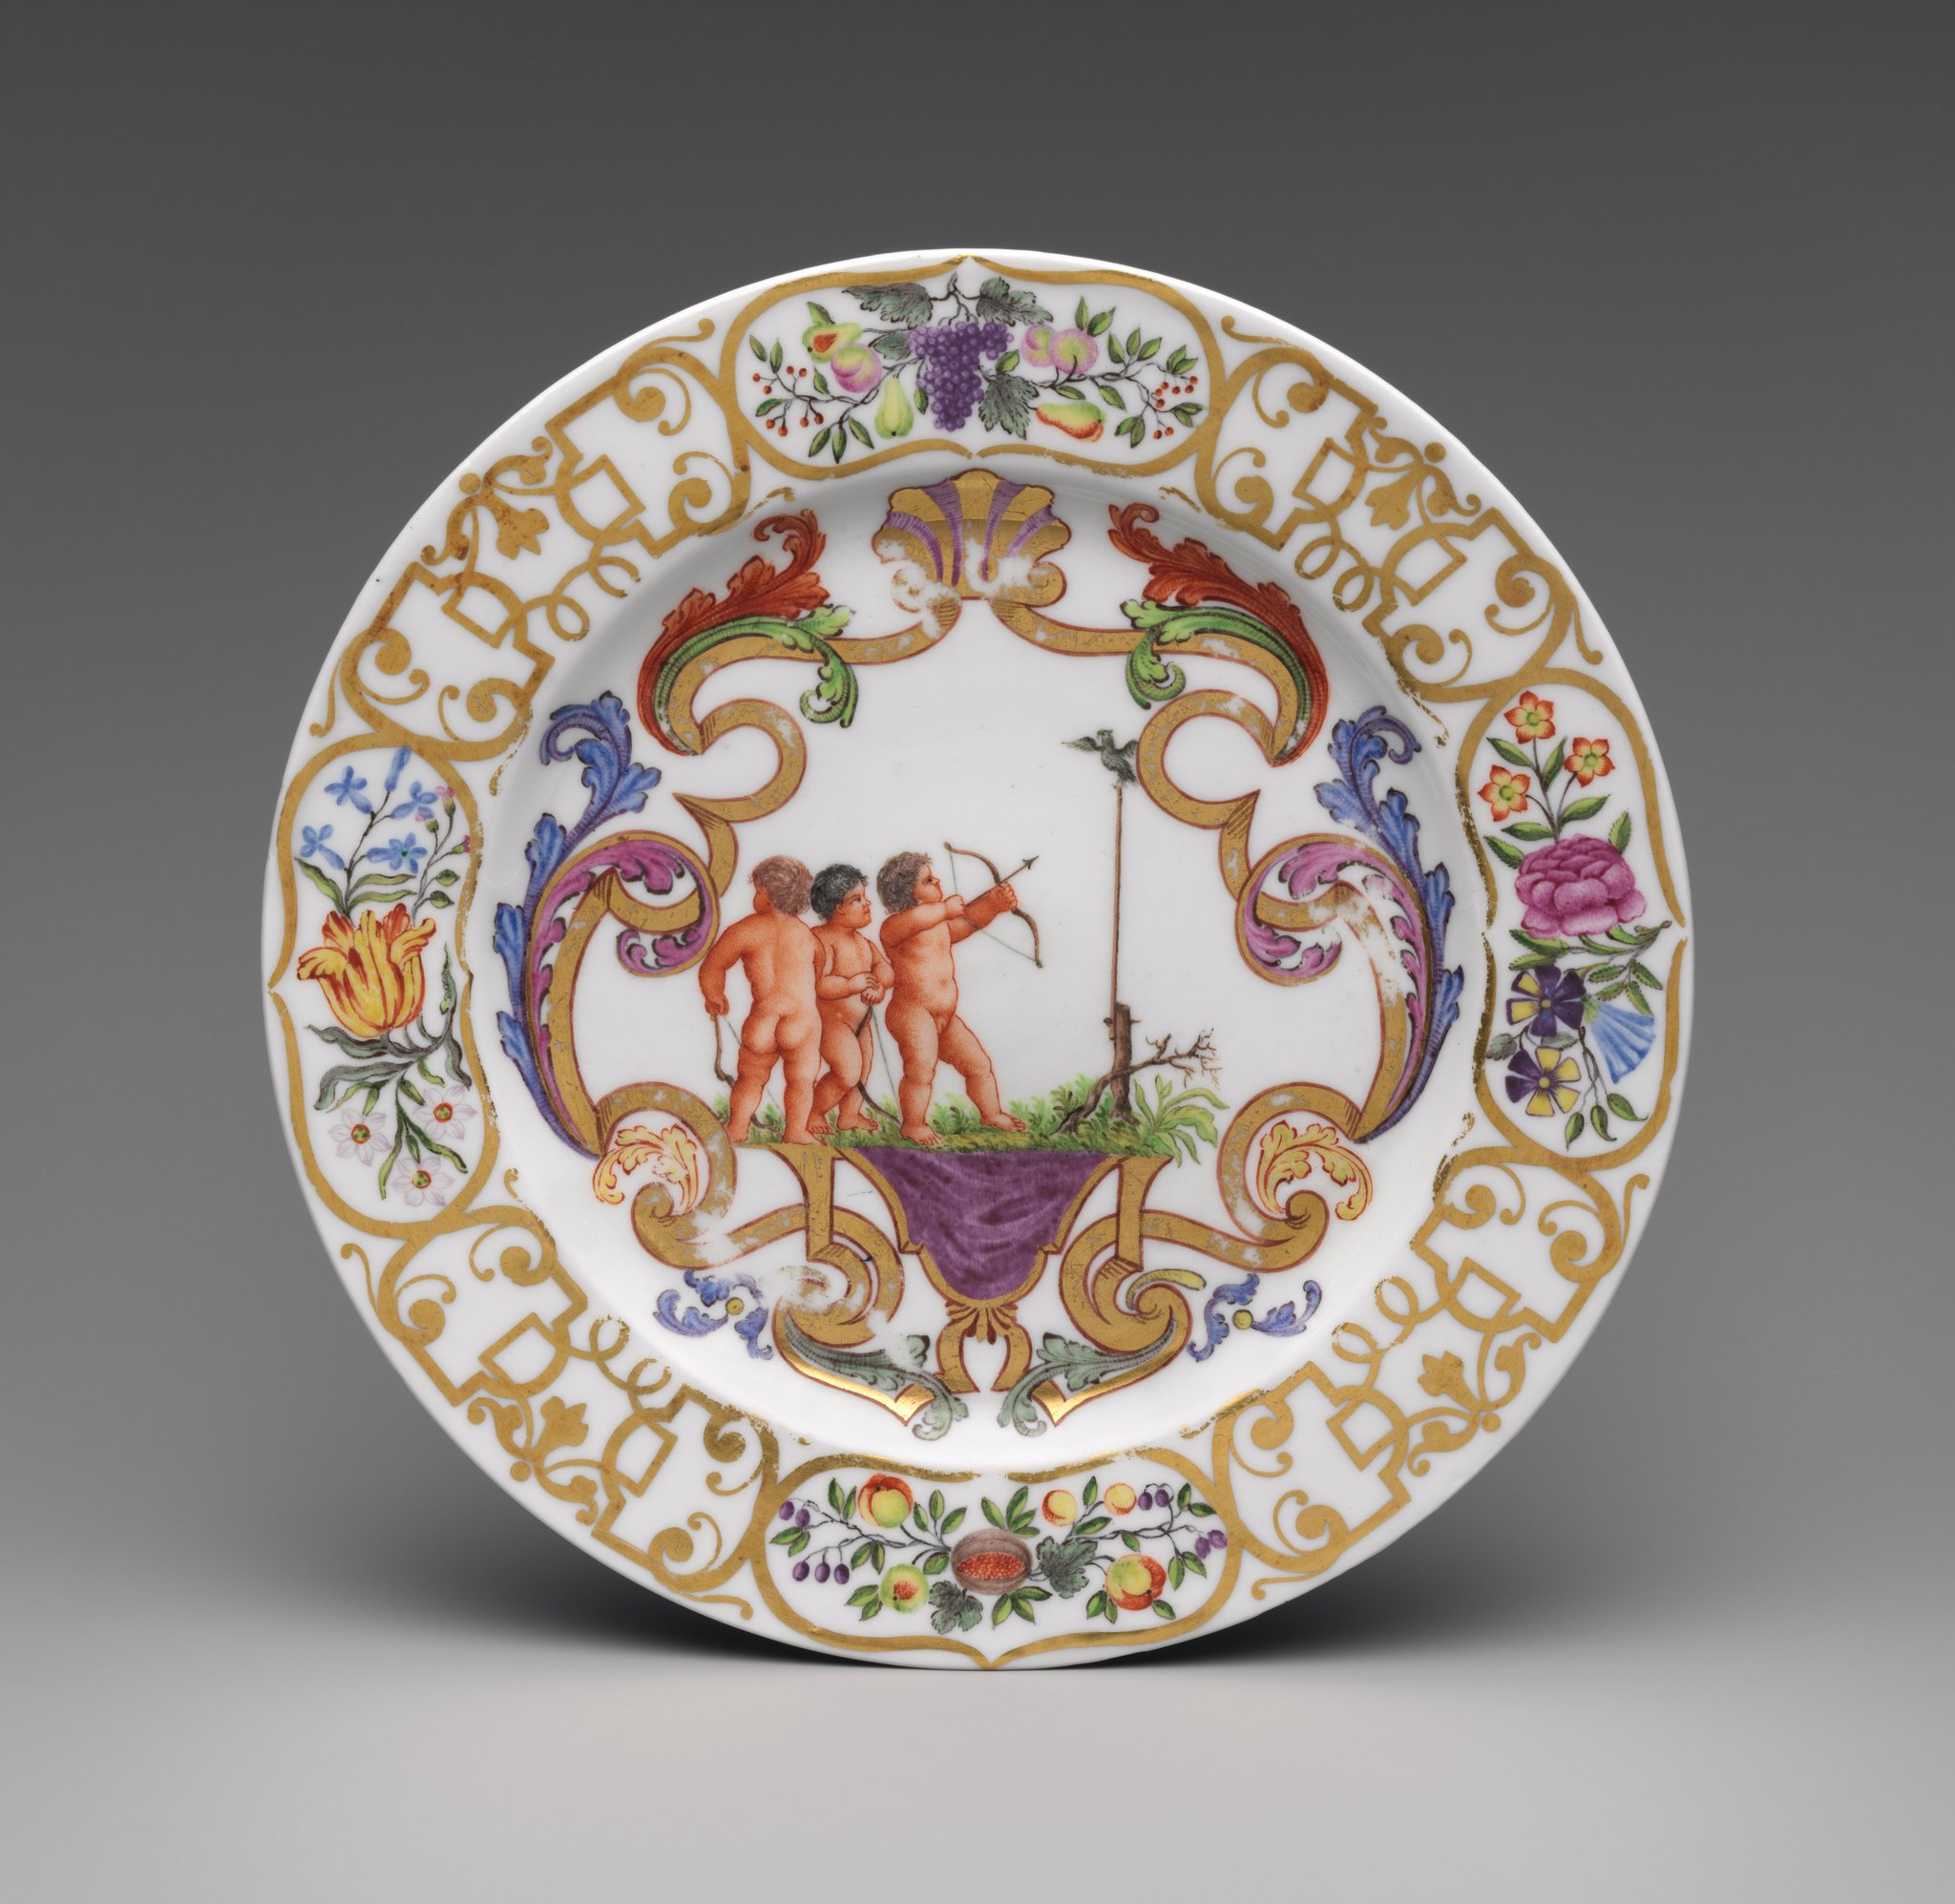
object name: plate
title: Plate (one of a pair)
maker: meissen manufactory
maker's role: manufactory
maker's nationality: german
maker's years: 1710-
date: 1740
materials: hard paste porcelain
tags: bow and arrow,fruit,boys,flowers